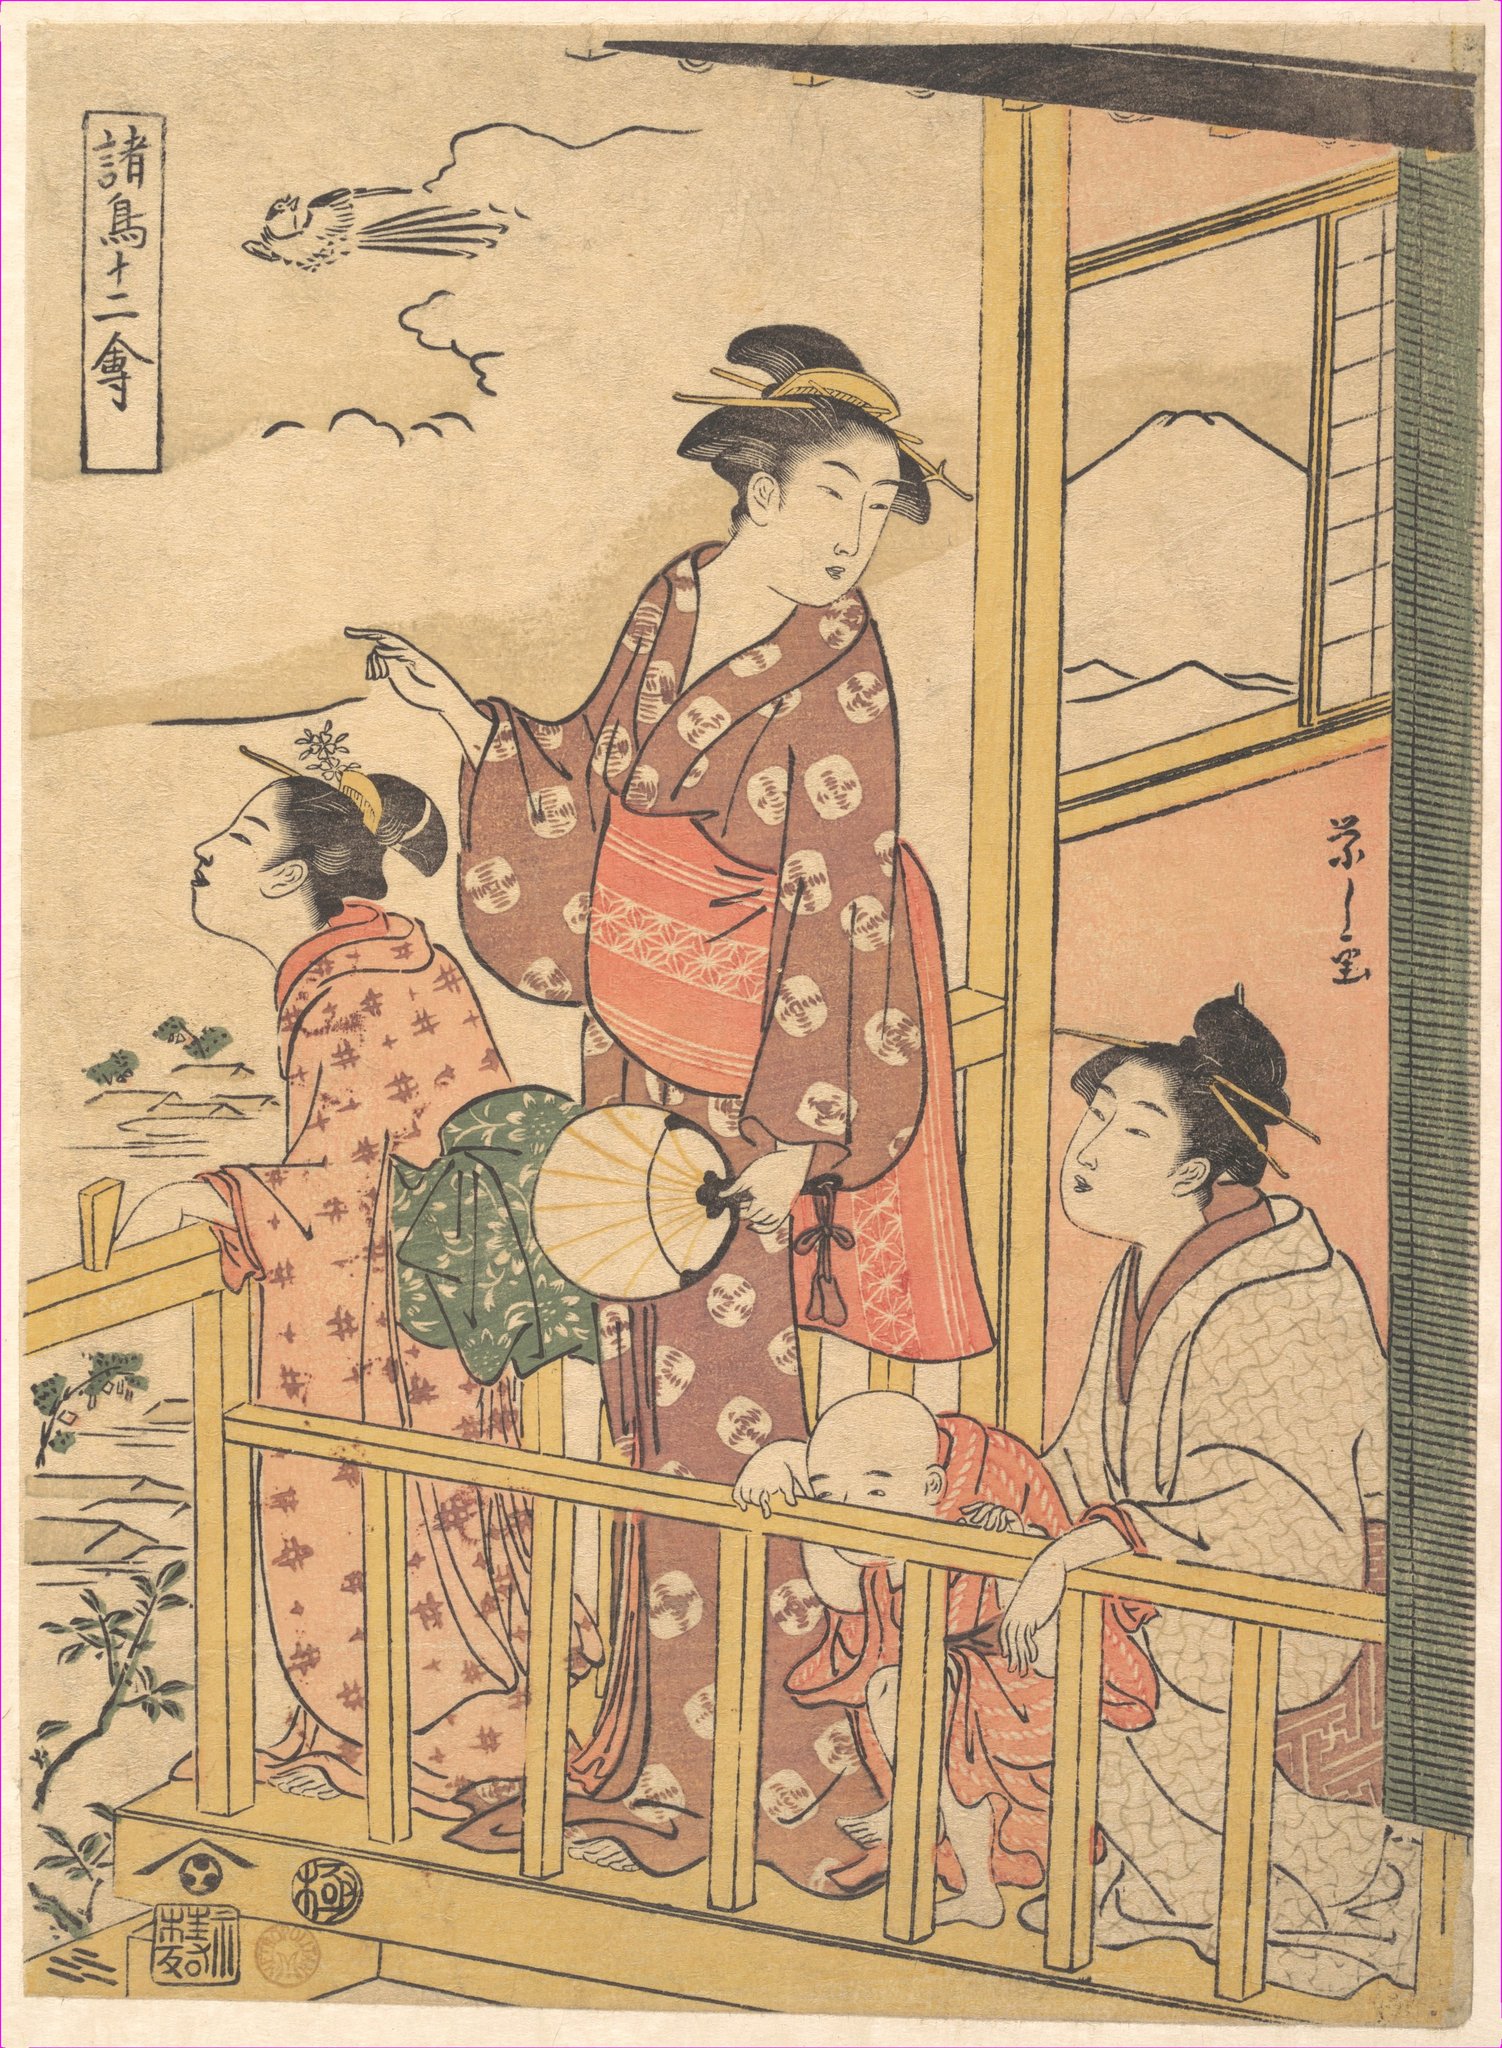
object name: print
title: A Long-Tailed Fowl (Onagadori), from the series Twelve Assorted Birds (Shochō jūnikin)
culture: japanese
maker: chōbunsai eishi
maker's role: artist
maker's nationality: japanese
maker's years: 1756-1829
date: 1791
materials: ink, paper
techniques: woodblock print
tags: fans,boys,women